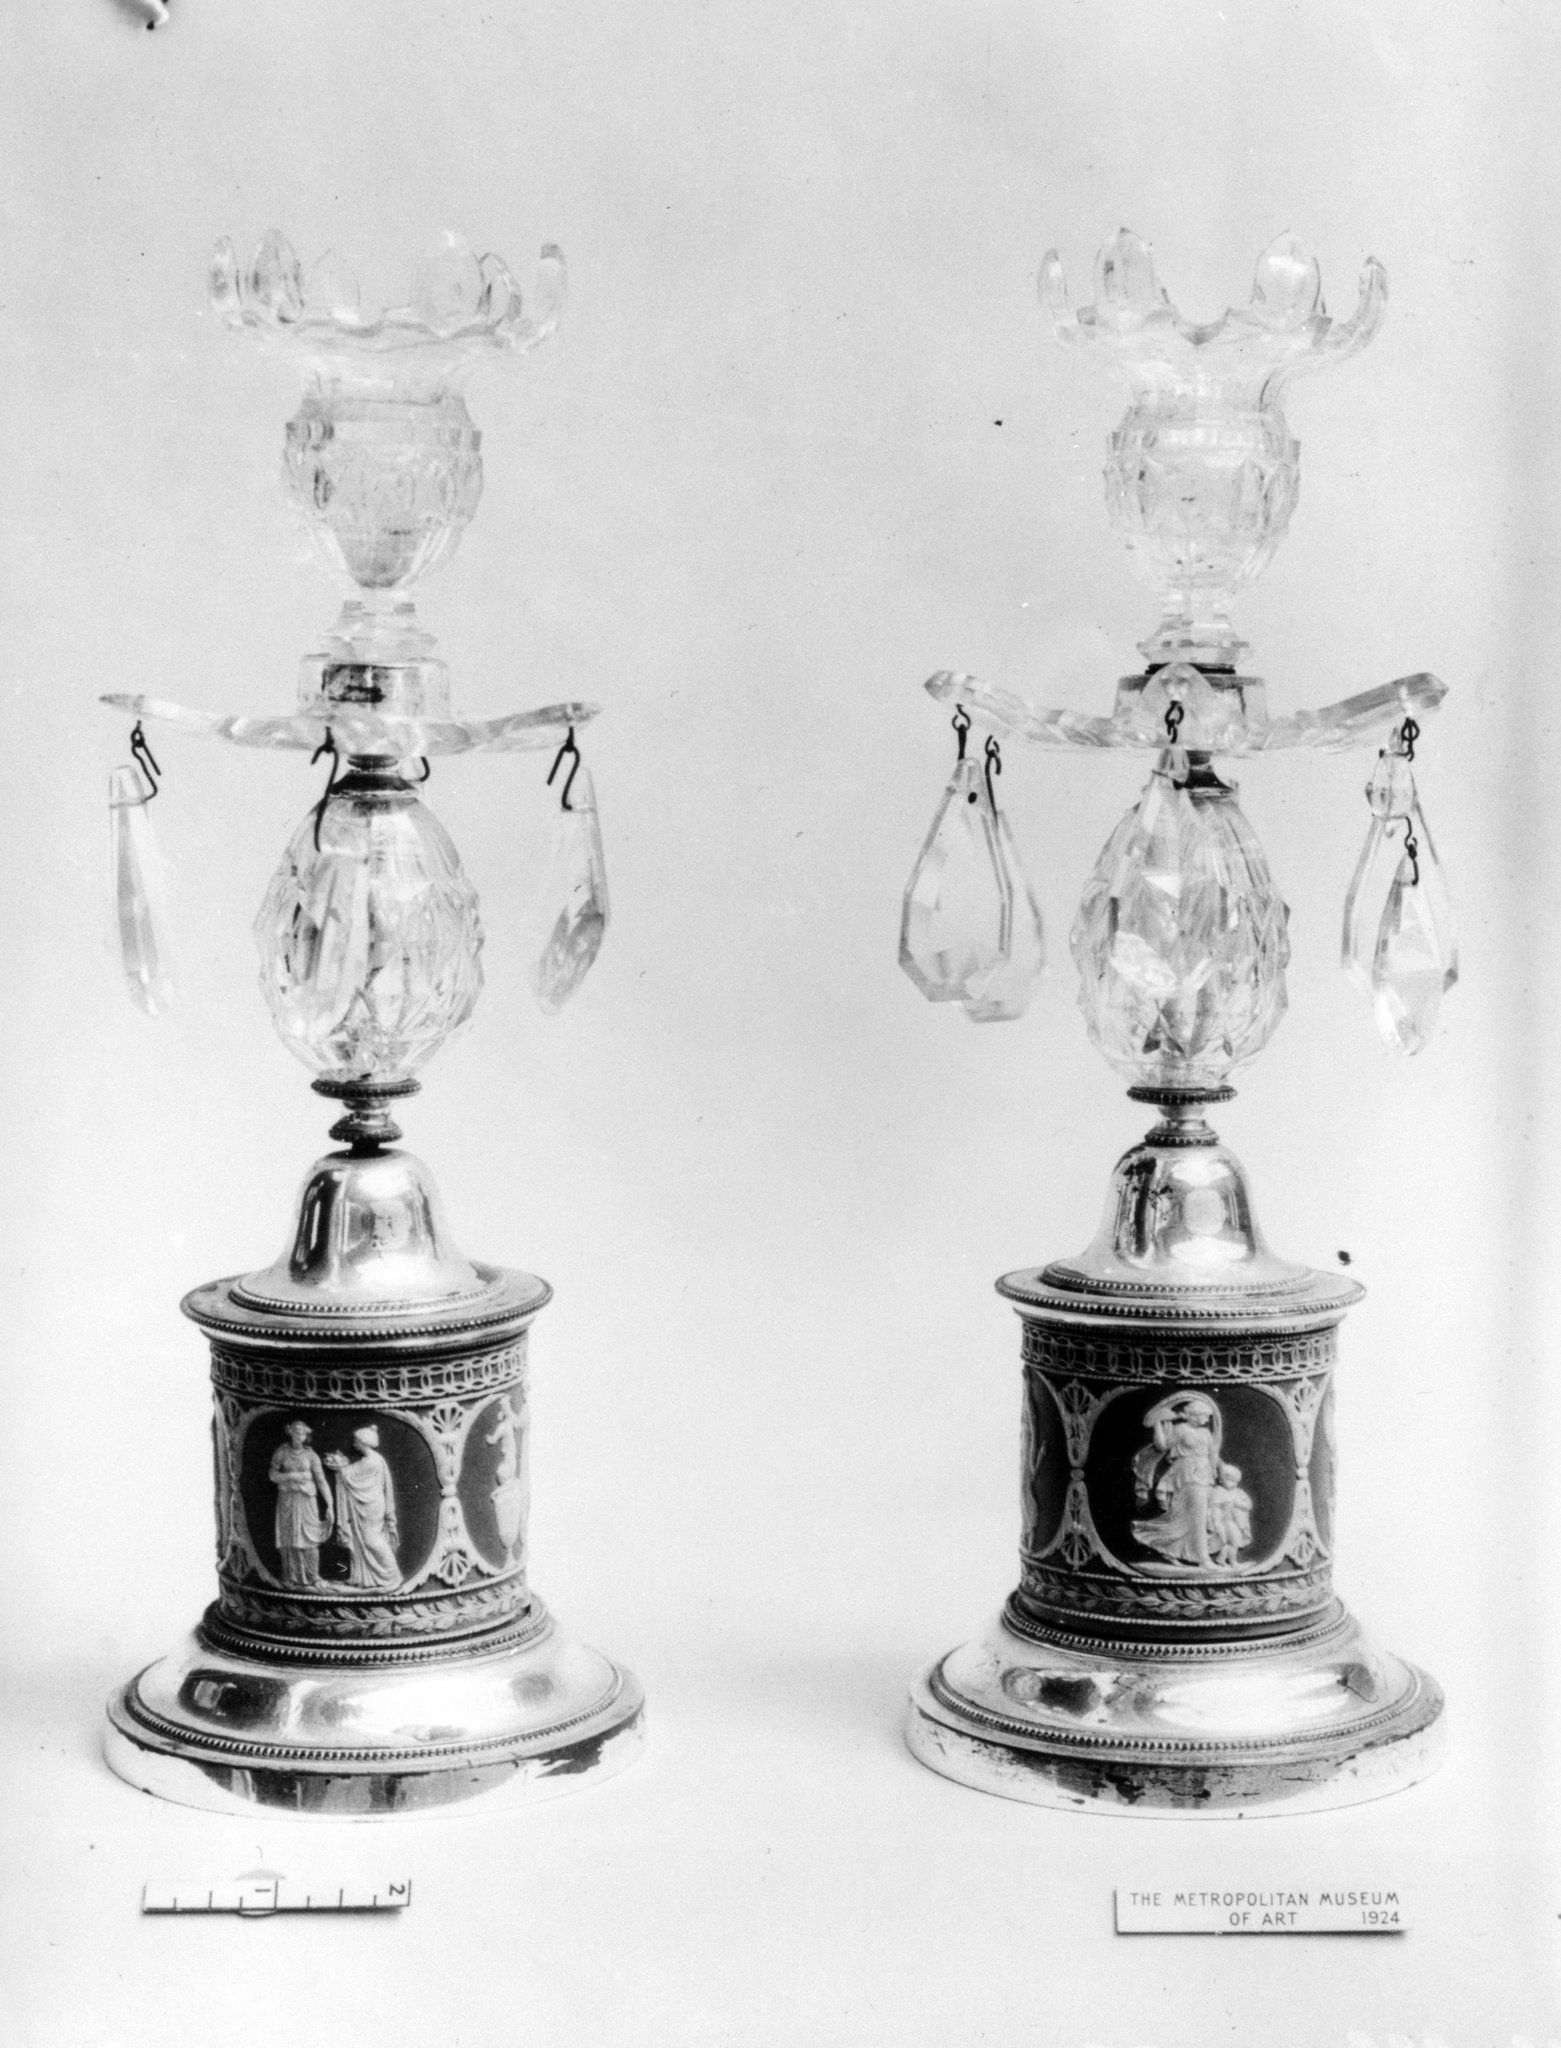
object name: candlestick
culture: british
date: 1800-1830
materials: earthenware, glass, metal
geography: england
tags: human figures